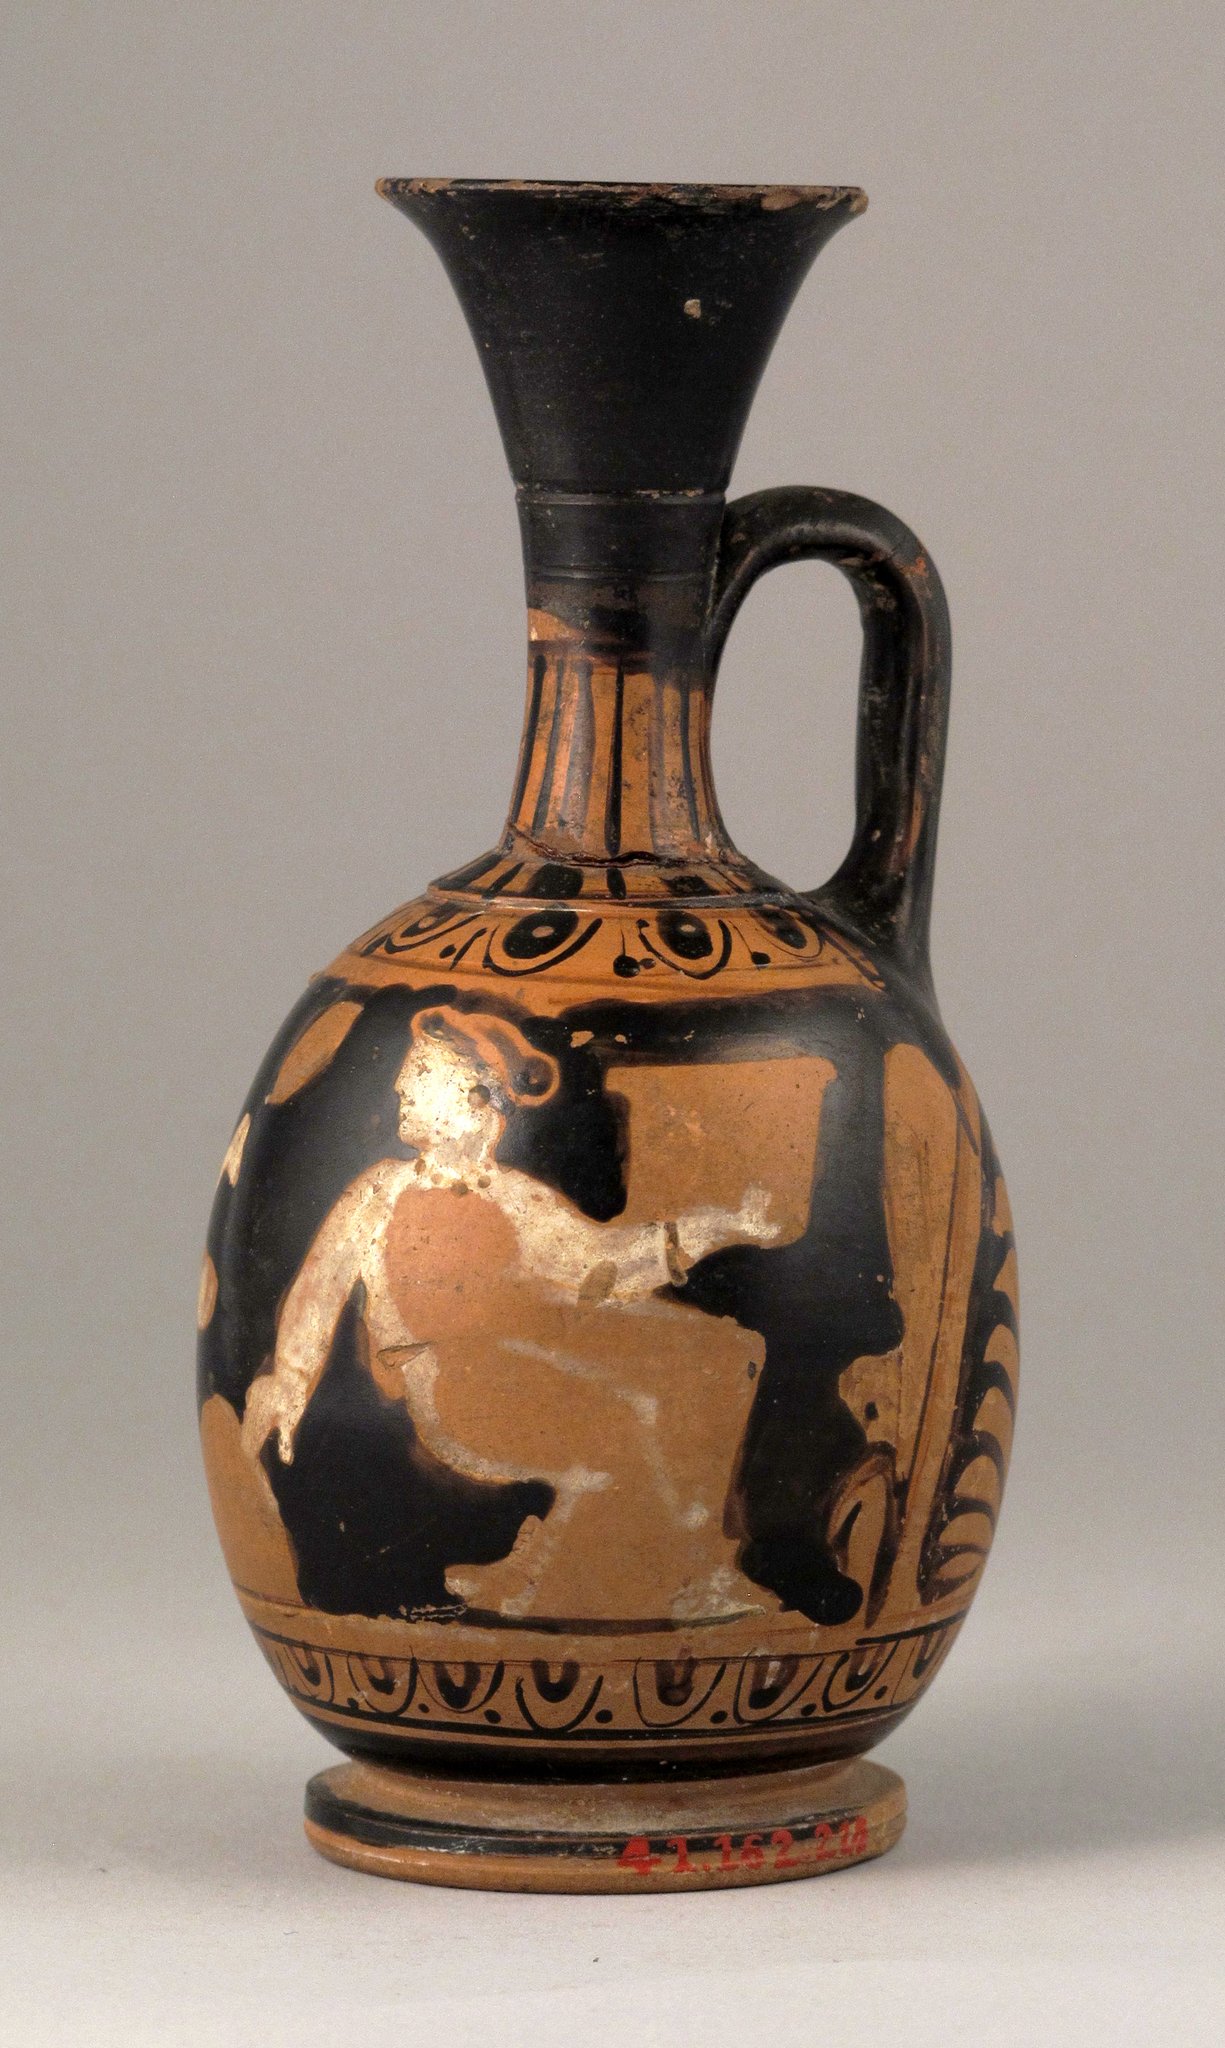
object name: squat lekythos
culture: greek, attic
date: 400-301 BCE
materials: terracotta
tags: women,eros